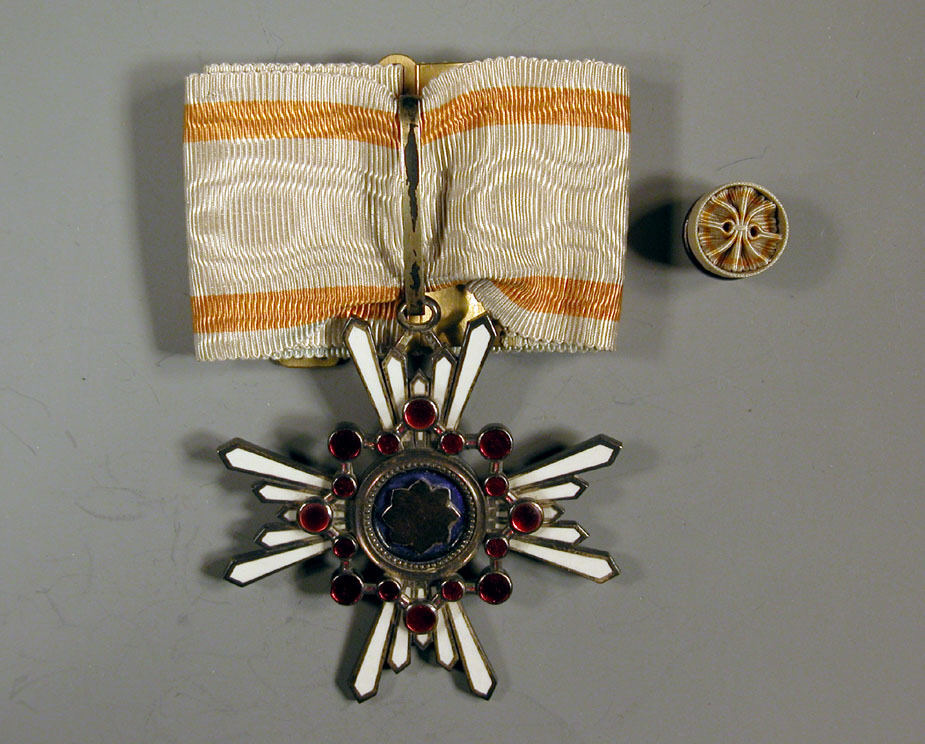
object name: medal and button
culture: japanese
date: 1867-1900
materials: ribbon